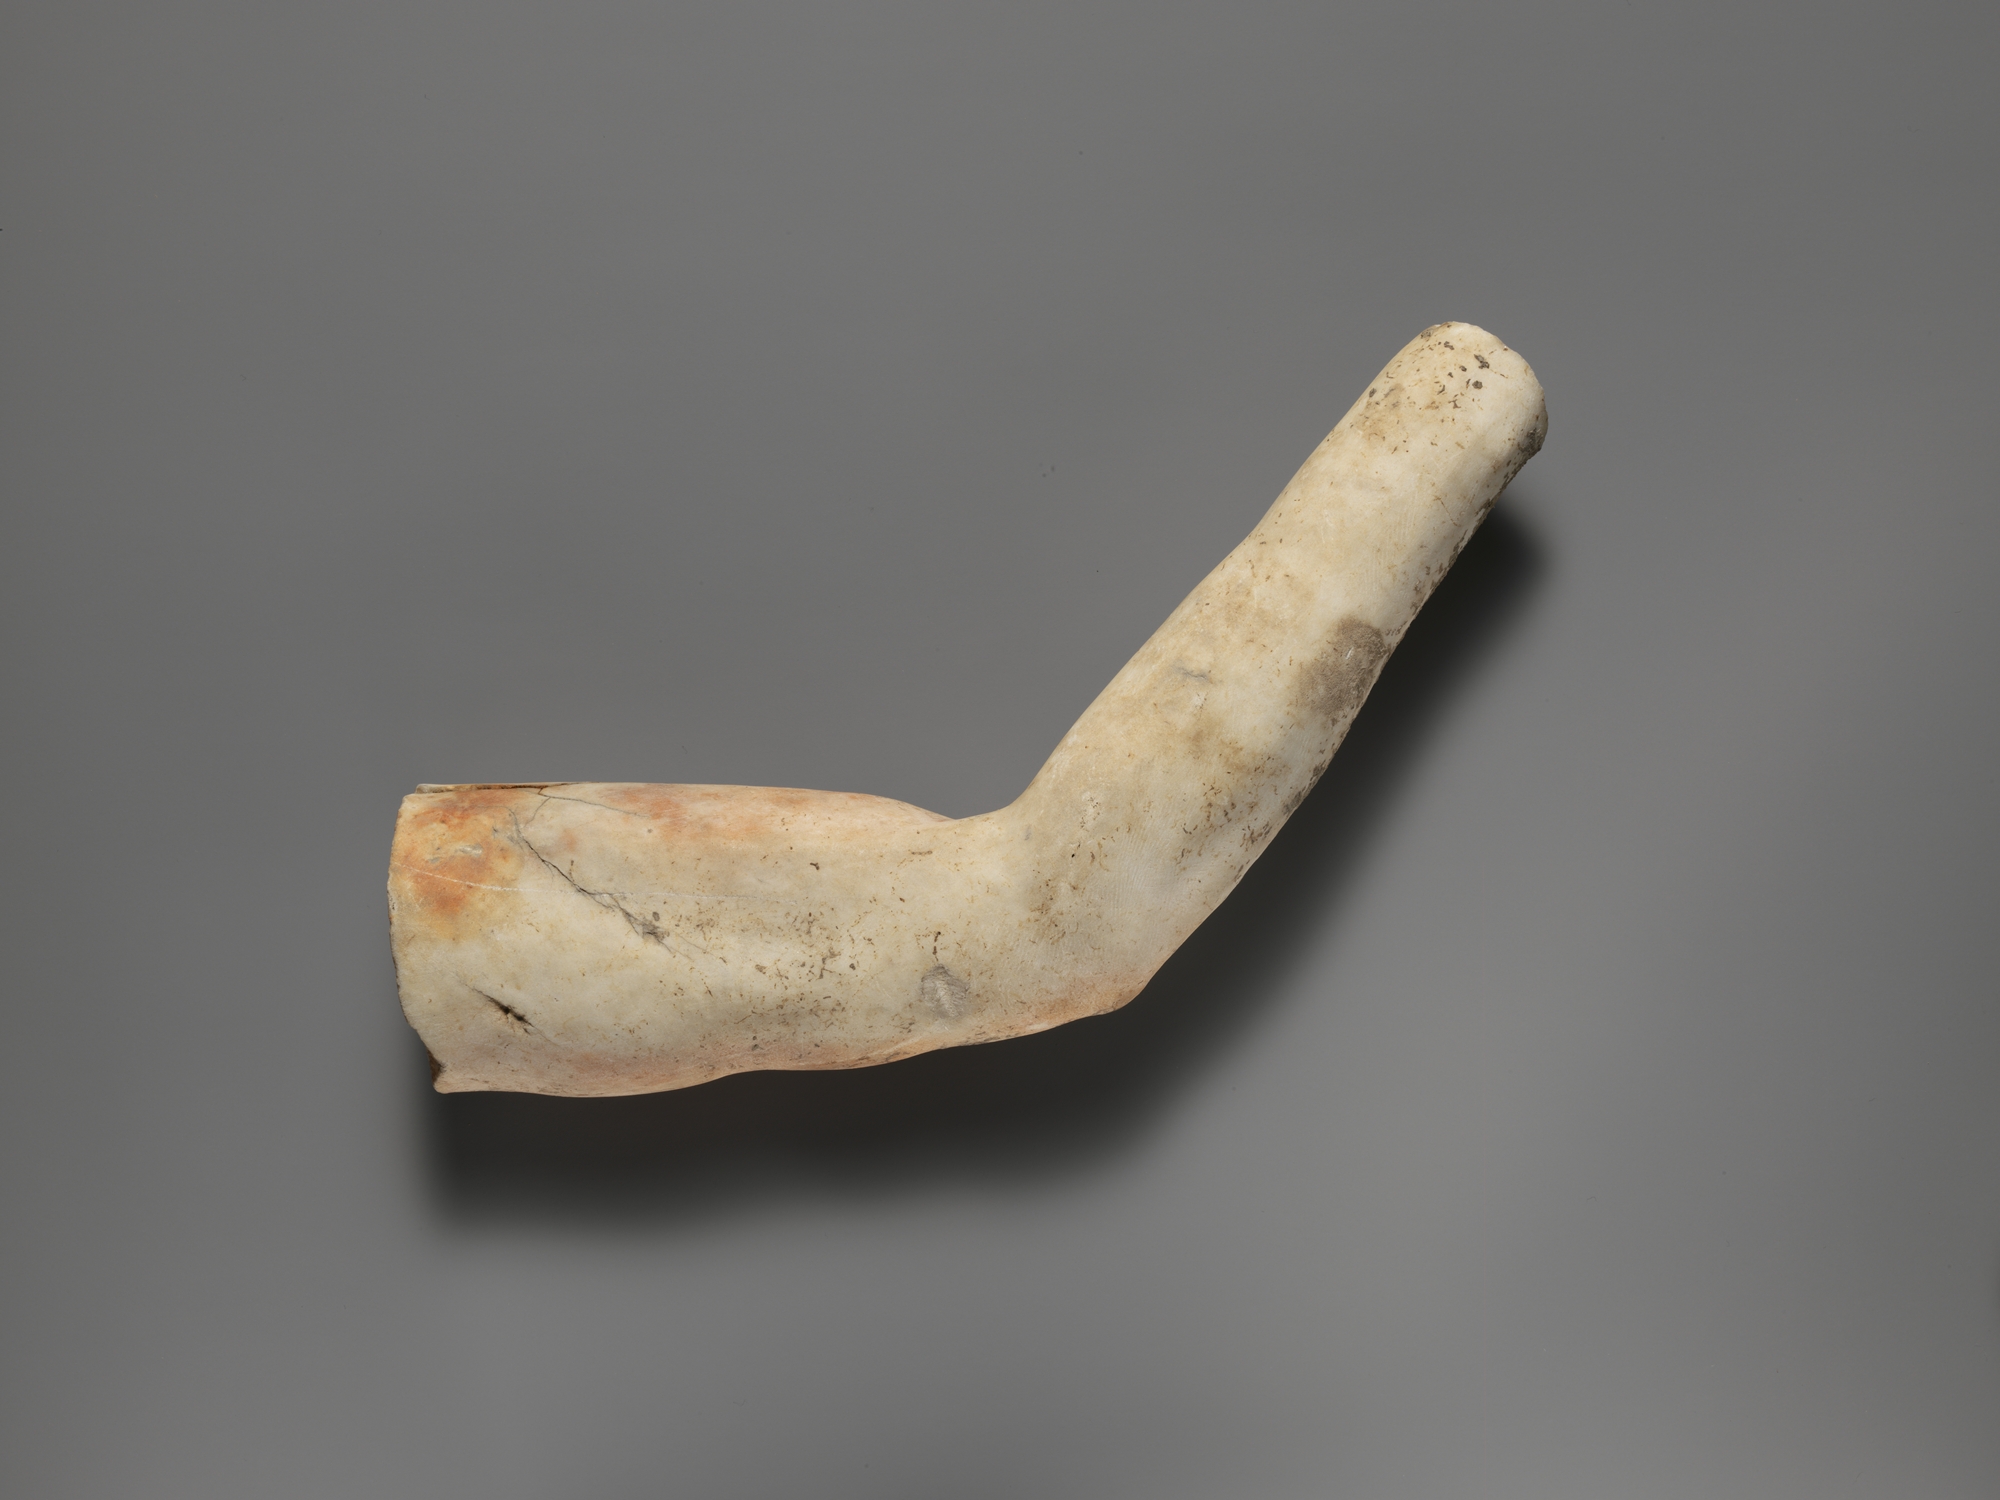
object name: arm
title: Marble arm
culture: roman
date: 670 BCE-330 CE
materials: marble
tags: hands